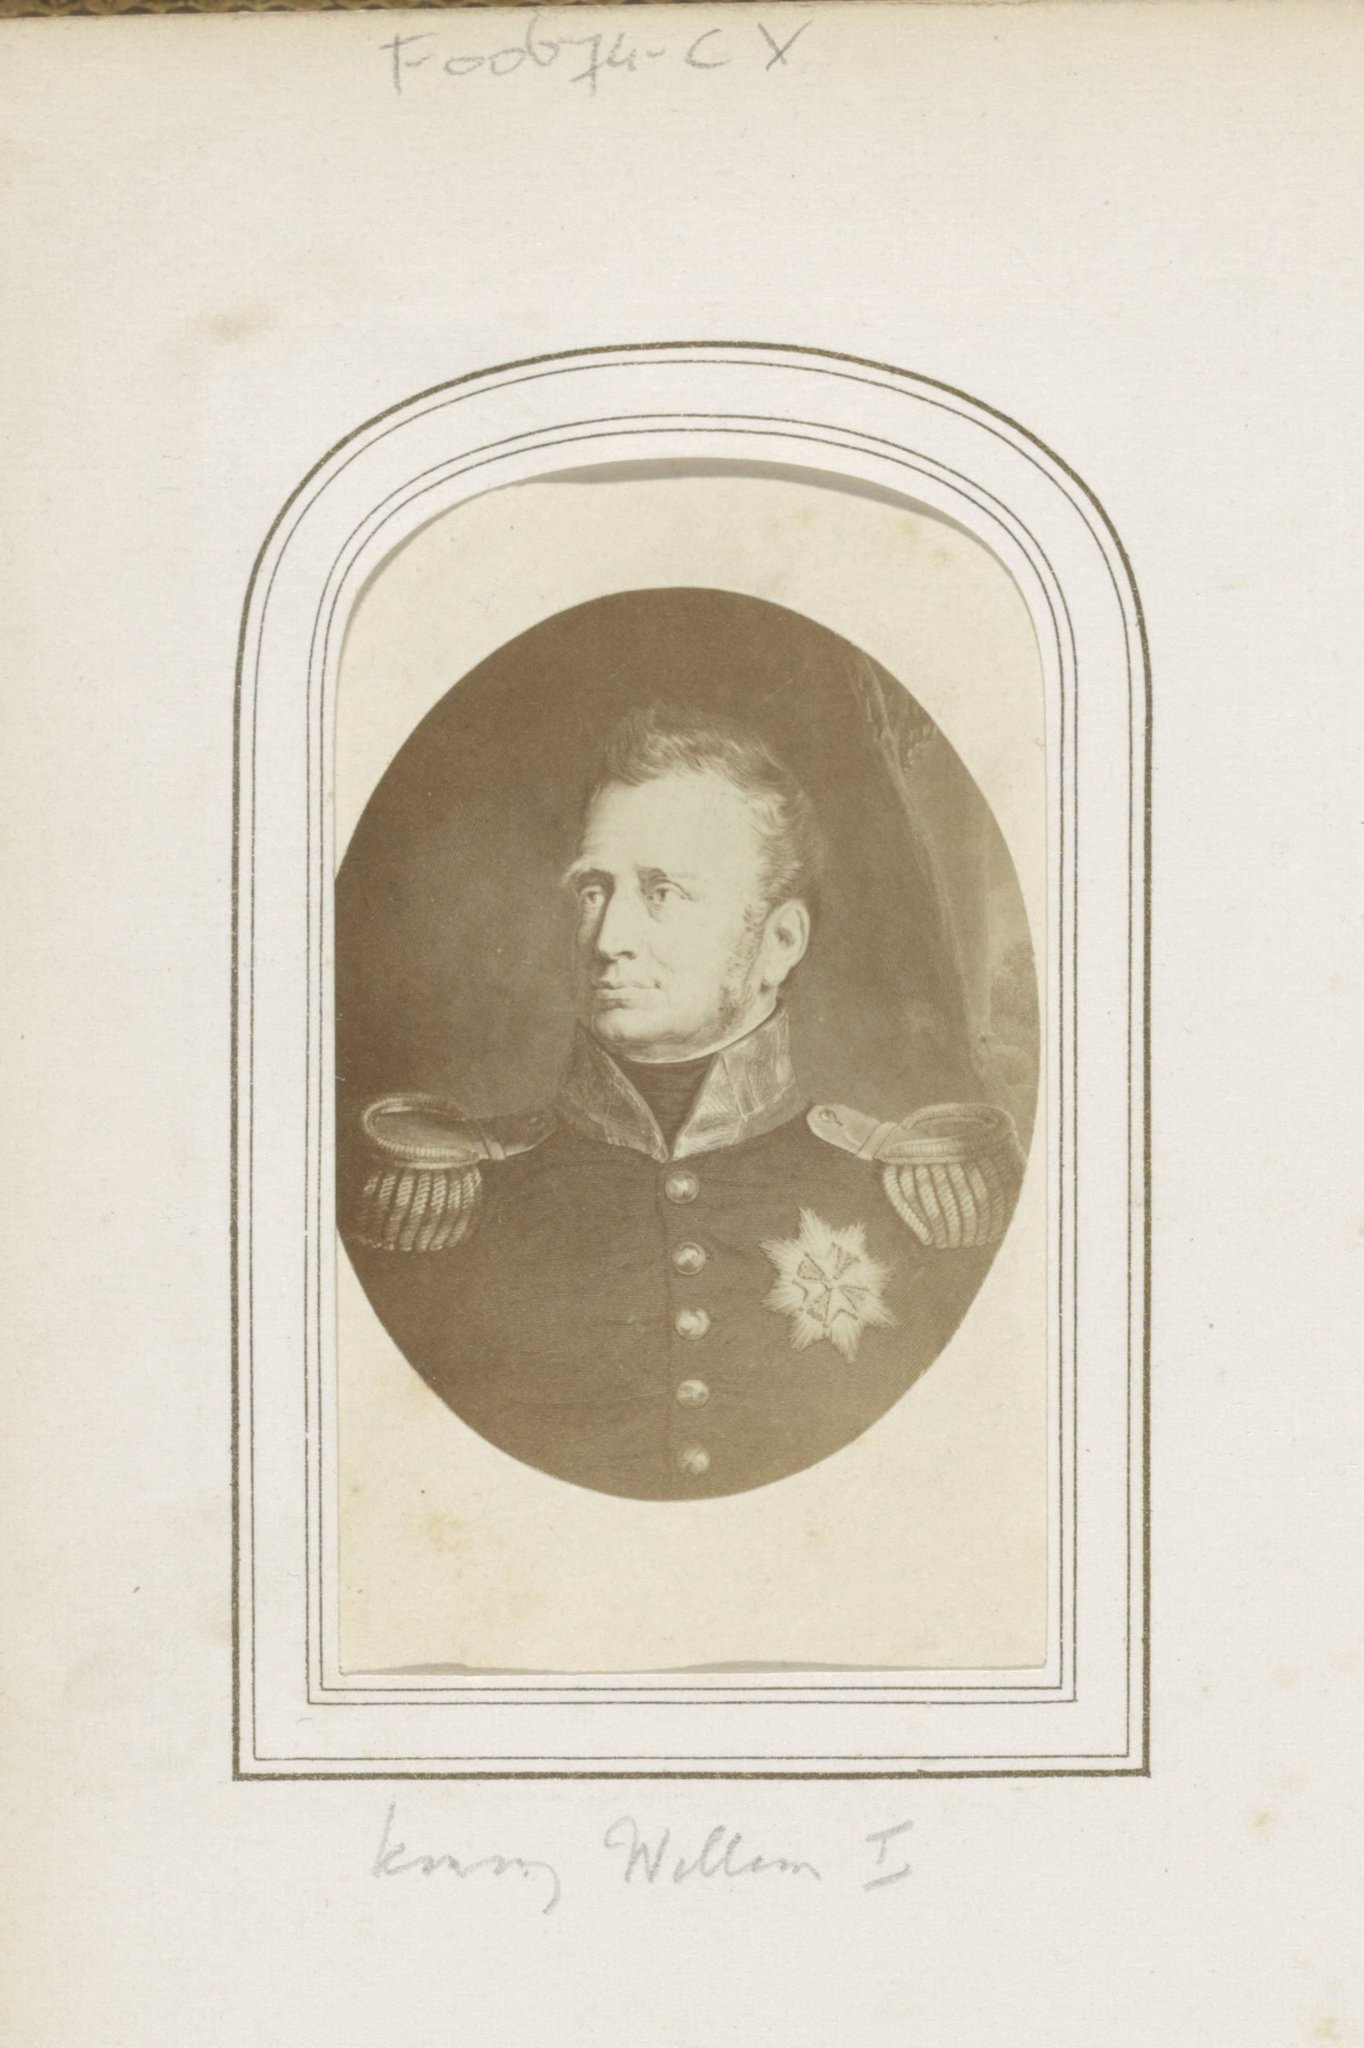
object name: photograph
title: Fotoreproductie van een gegraveerd portret van koning Willem I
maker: Anonymous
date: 1855-1870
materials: cardboard, paper, photographic support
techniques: albumen print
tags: the hague, berlin, william i of the netherlands, sideburns, historical persons, ruler, sovereign, decorations, honours (as symbols of the state, etc.), (military) uniforms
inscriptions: inscription: ‘Willem I’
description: Onderdeel van Fotoalbum met 123 cartes-de-visite van leden van Europese vorstenhuizen, politici en bekende personen.